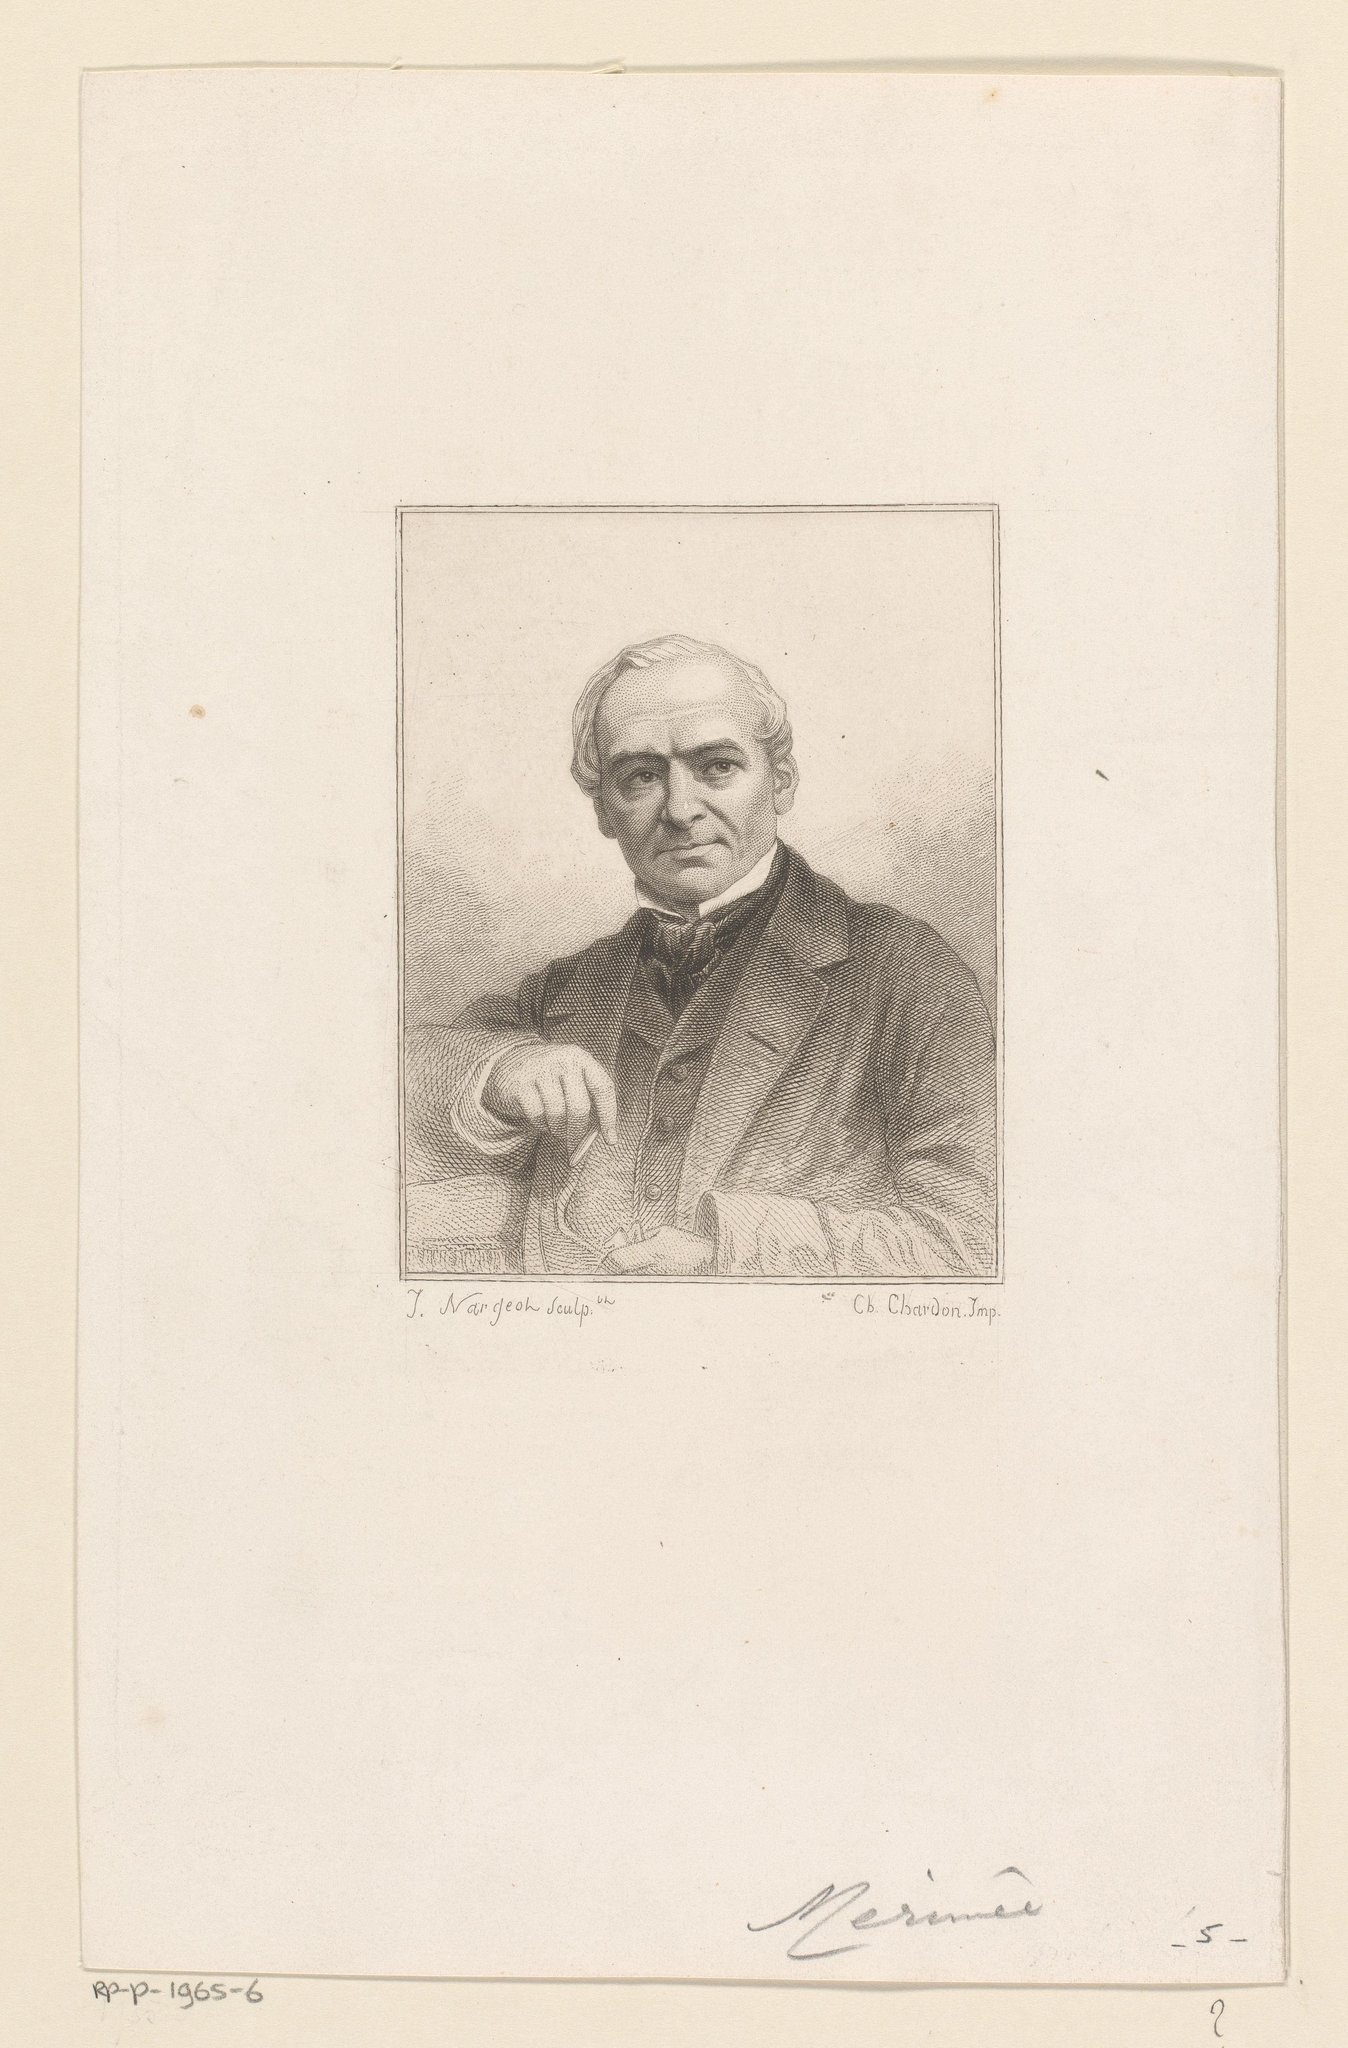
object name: print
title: Portret van Prosper Mérimée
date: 1820-1865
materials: paper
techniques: engraving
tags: historical persons